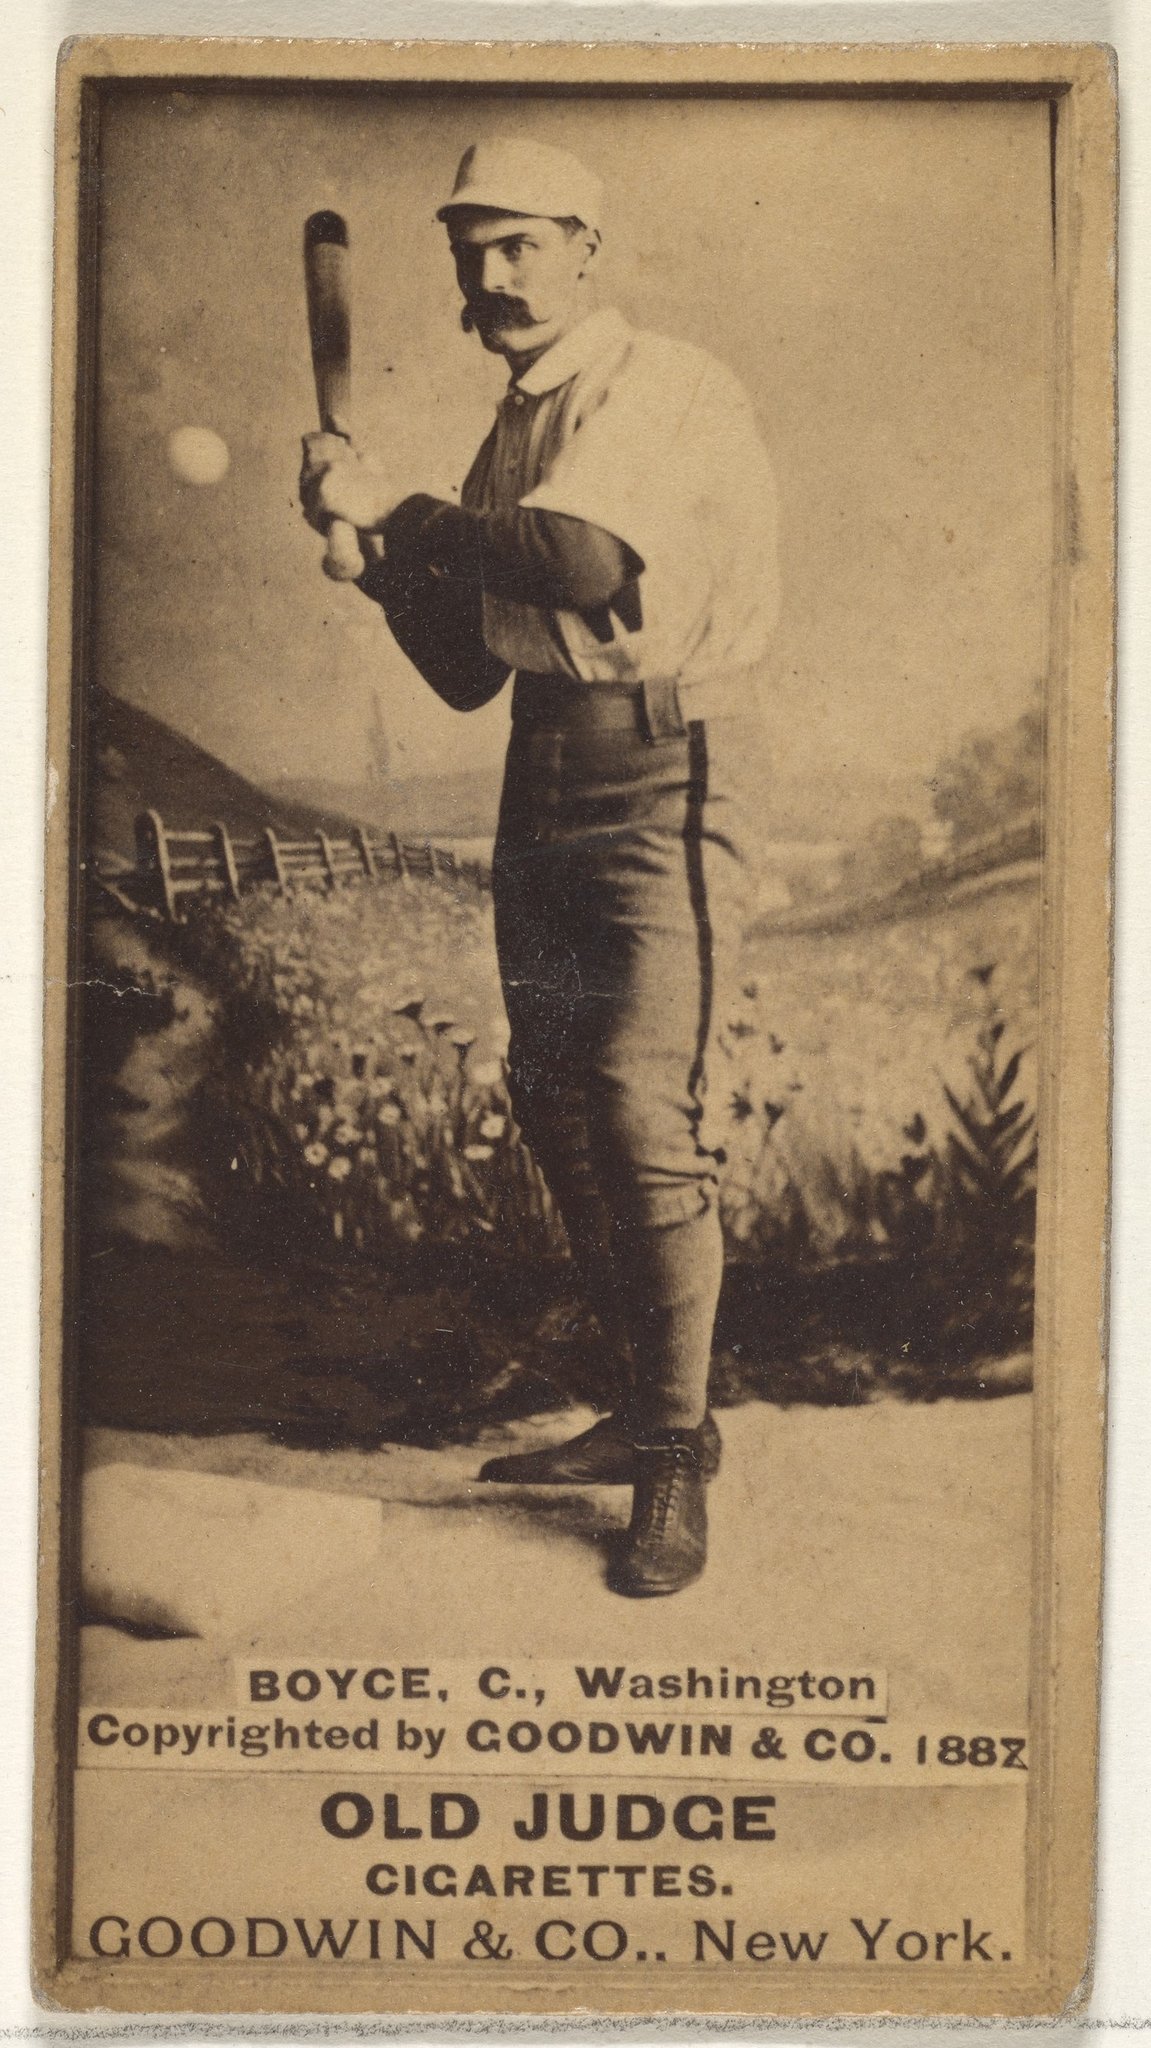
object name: baseball card, photograph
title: Boyce, Catcher, Washington, from the Old Judge series (N172) for Old Judge Cigarettes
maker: goodwin & company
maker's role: publisher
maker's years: 1850-1950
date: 1887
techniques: albumen silver print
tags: men,portraits,baseball,athletes